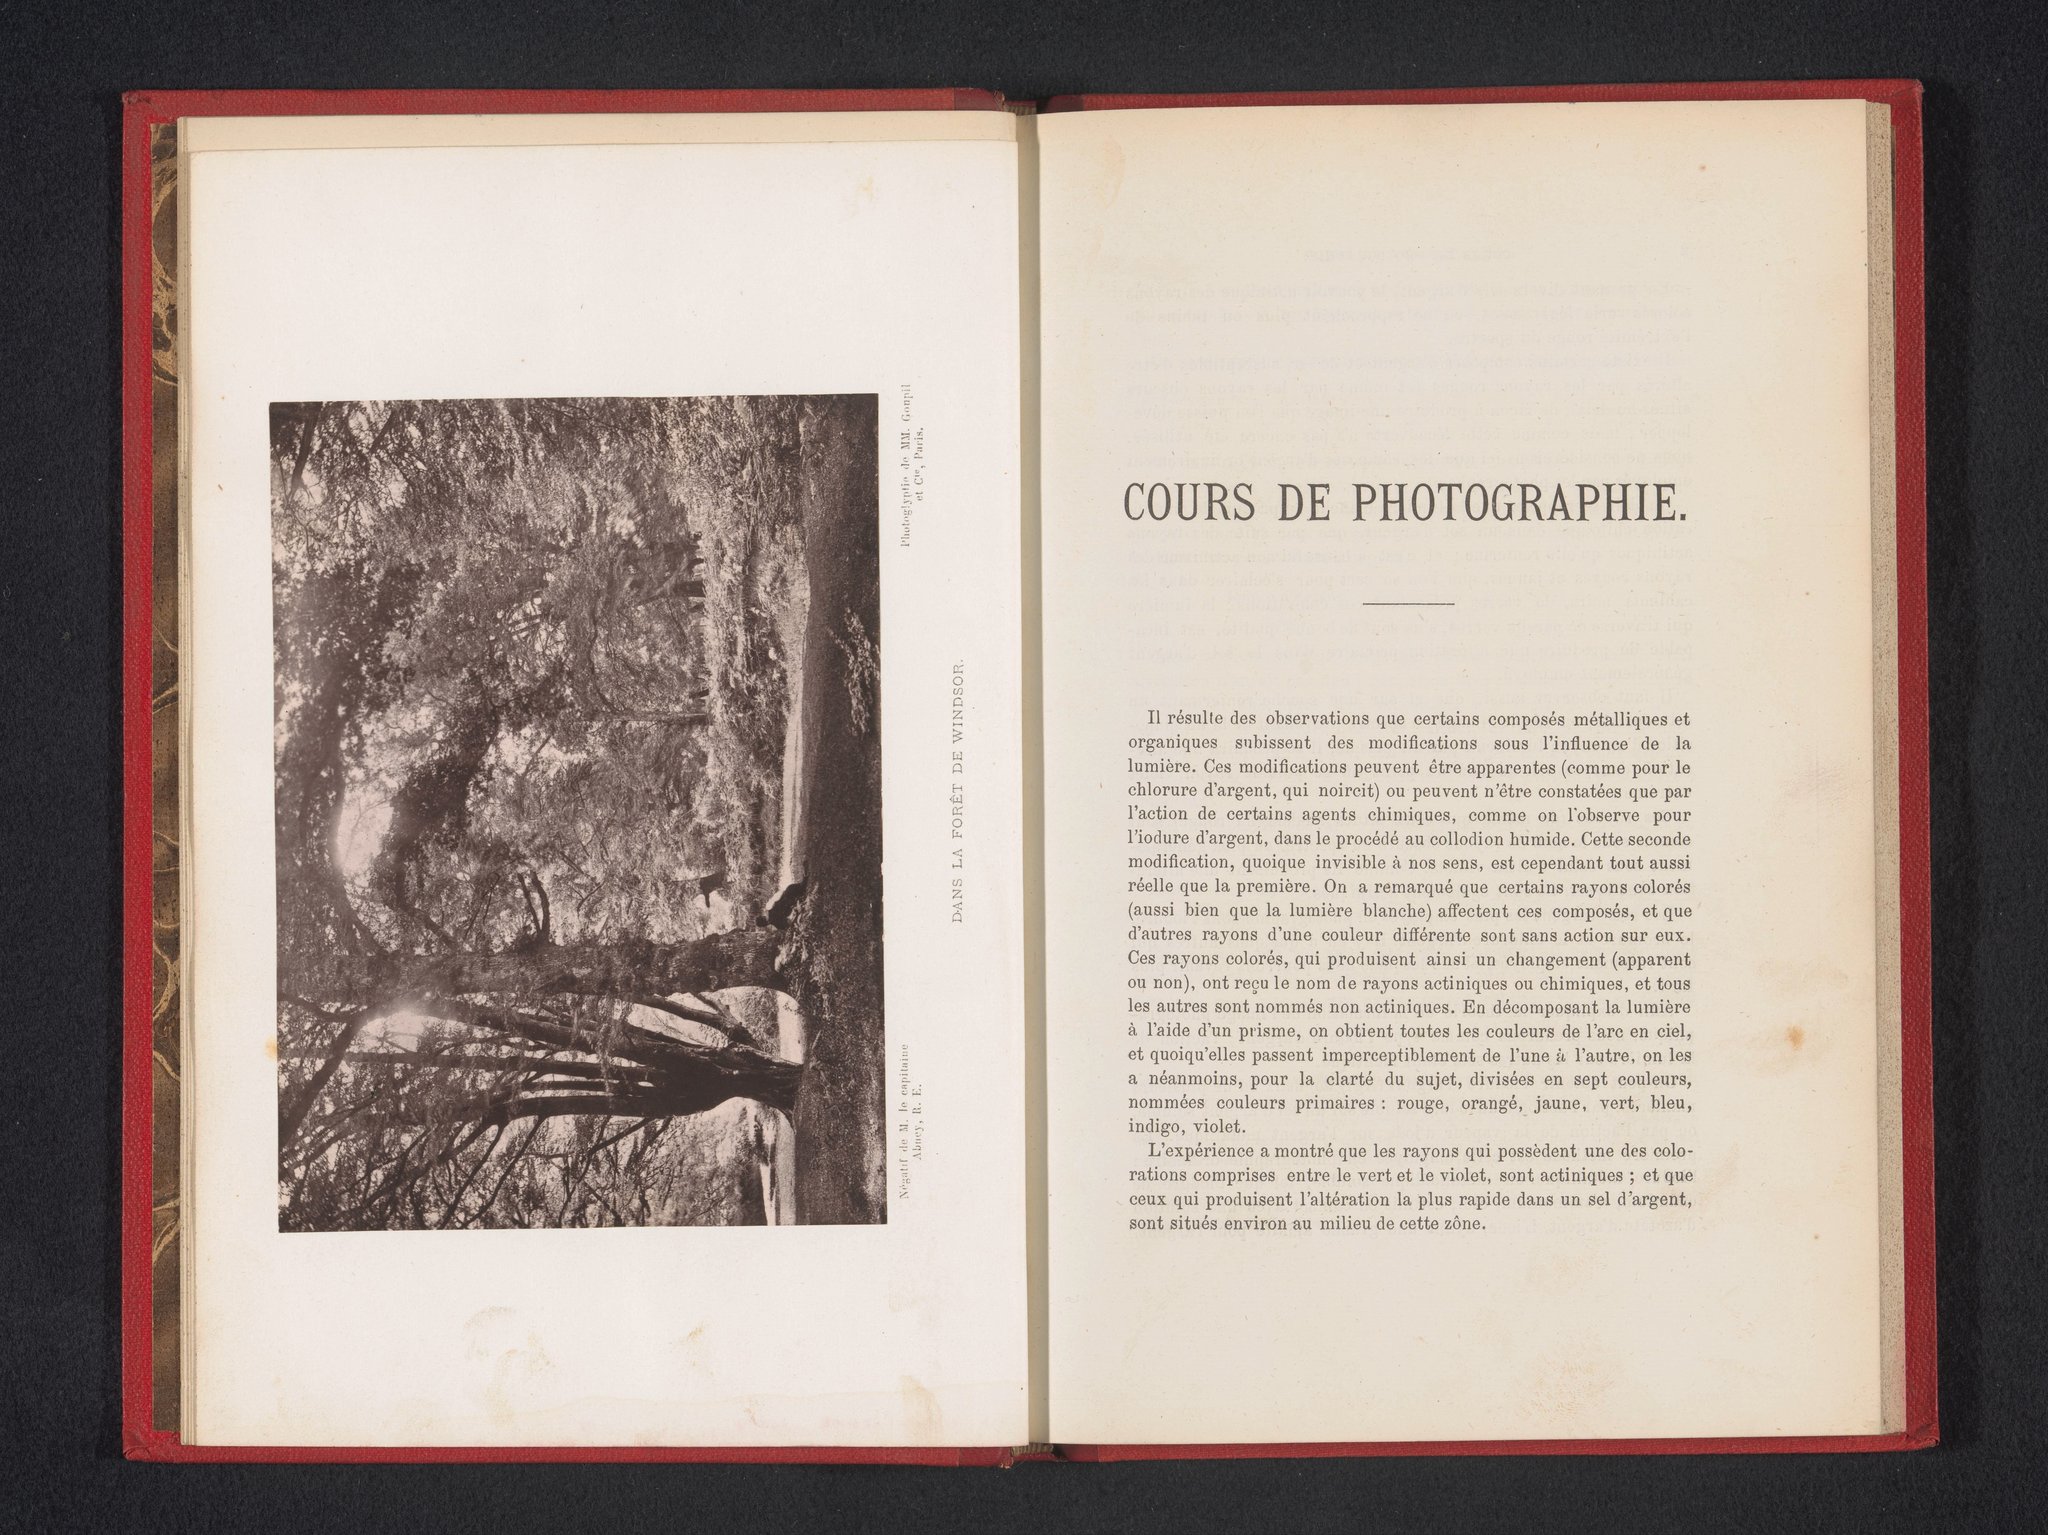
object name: photomechanical print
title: In het bos bij Windsor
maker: r.e. abney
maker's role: fotograaf, kapitein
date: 1872-1877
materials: paper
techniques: woodburytype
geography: windsor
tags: forest, wood